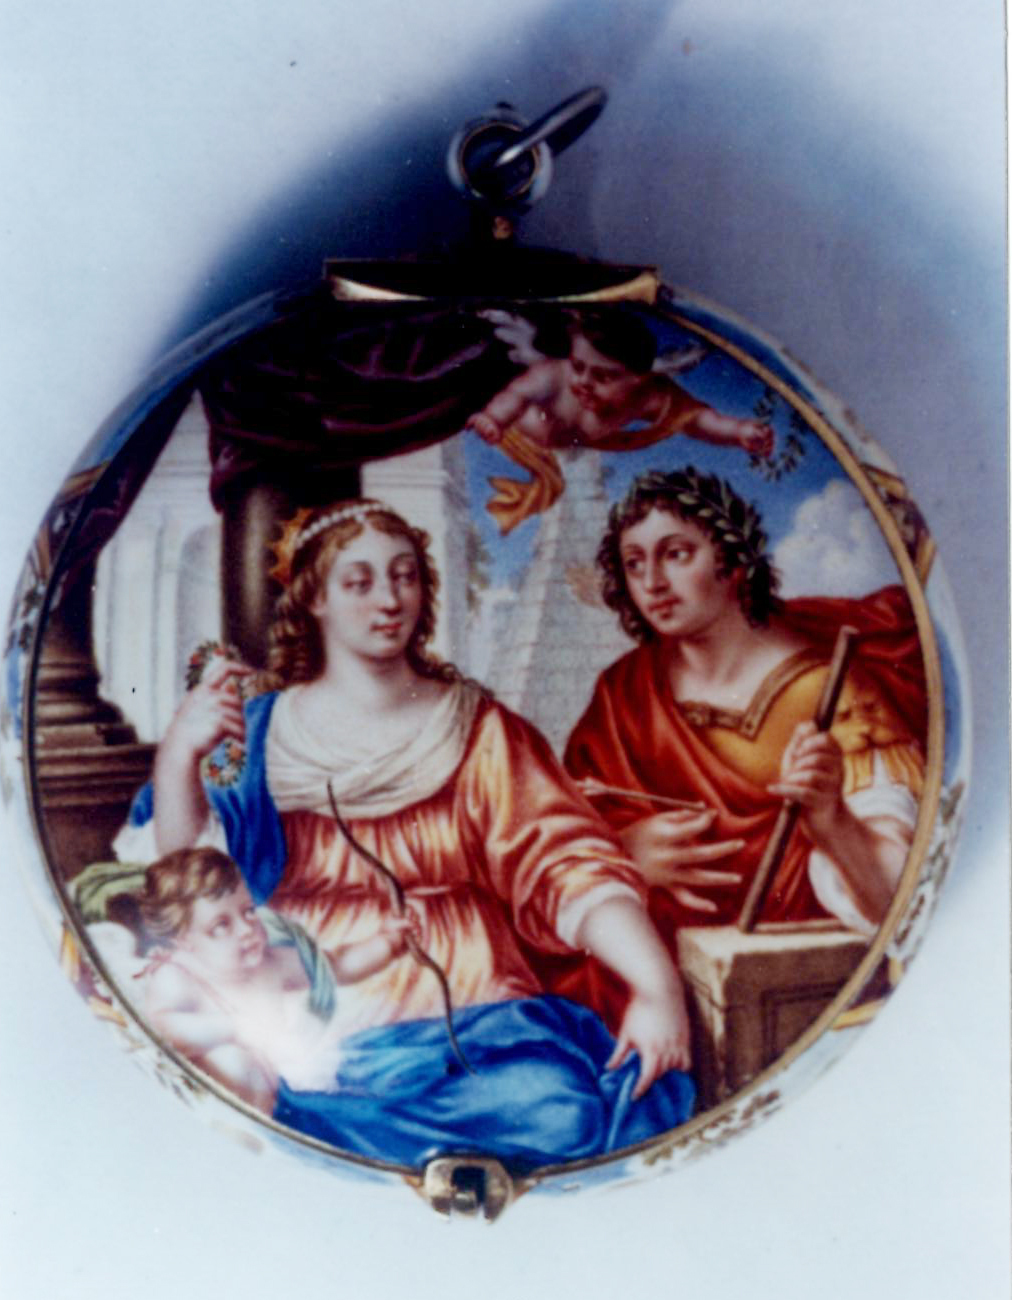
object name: watch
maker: jacques goullons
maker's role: maker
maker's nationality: french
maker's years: 1626-1671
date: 1650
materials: enamel, gold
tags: men,women